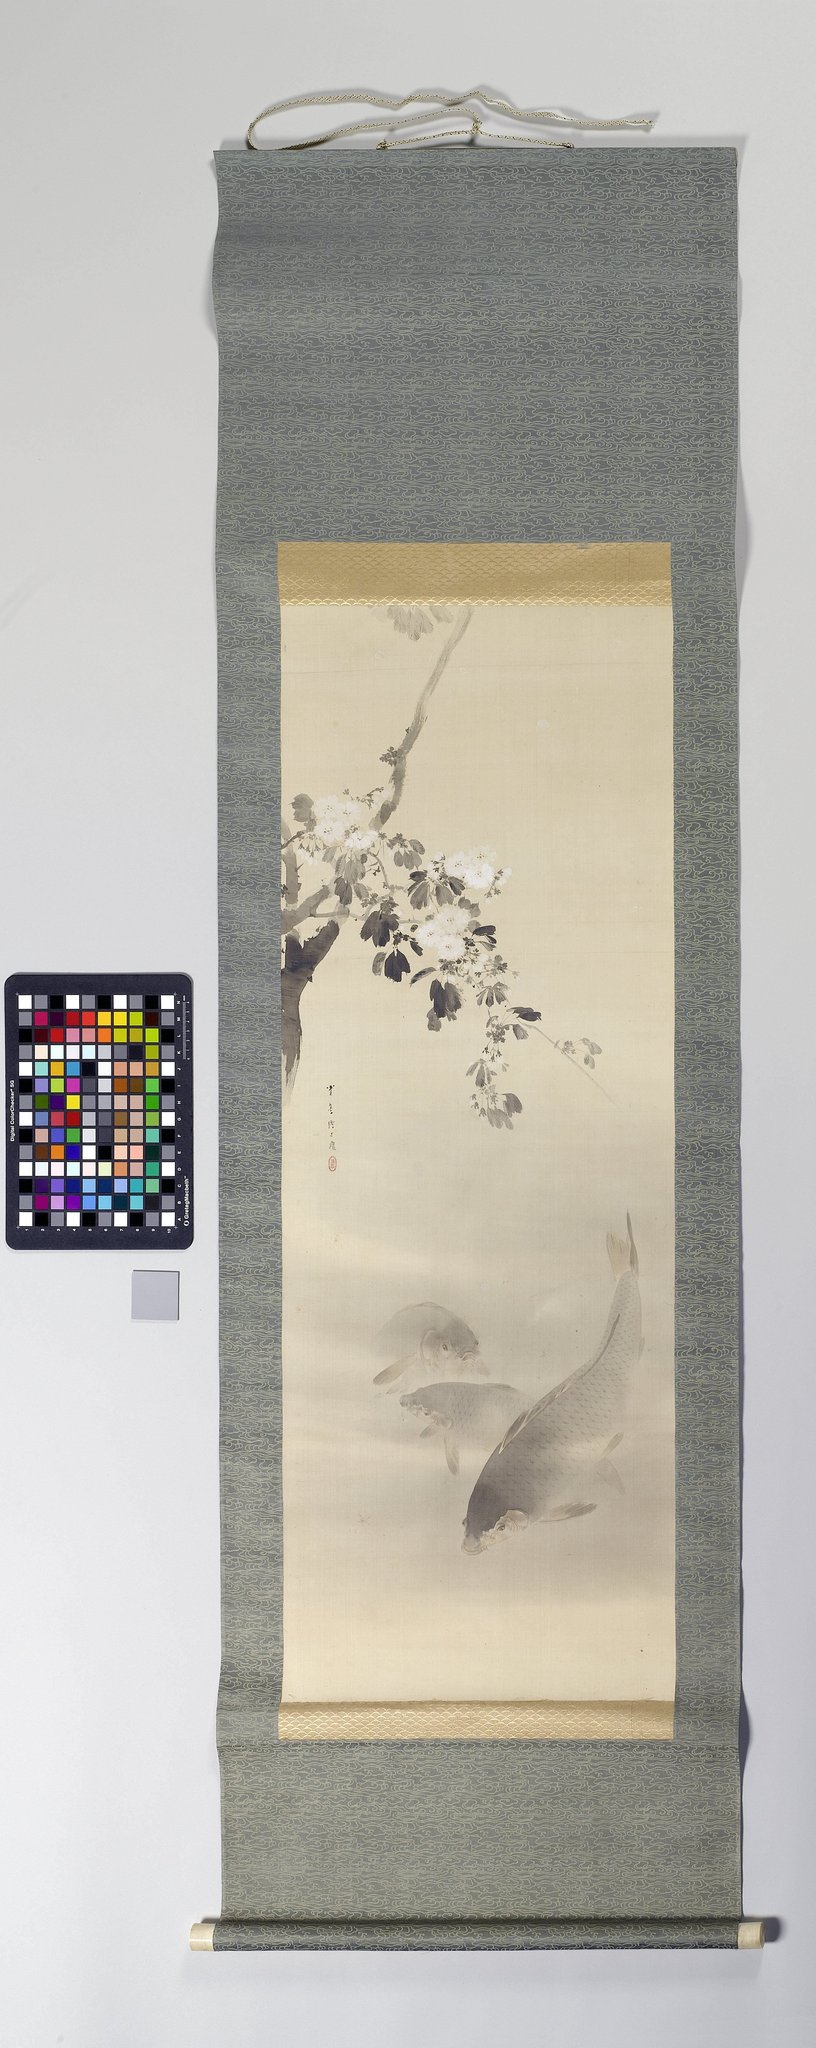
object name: hanging scroll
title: The Four Seasons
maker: watanabe seitei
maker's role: print maker, publisher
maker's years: 1851-1918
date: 1890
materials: ink, silk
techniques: painted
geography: tokyo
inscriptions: seal: ‘Seitei’, signature: ‘Seitei Watanabe’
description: Seitei was a talented painter of animals and flowers. He made prints and paintings on the basis of painstaking nature studies. Here as well he devoted much attention to the cherry blossoms and the detailing of the creatures, for instance the wings of the dragonfly in the painting of summer. In contrast, the waterfall in the background is rendered in broad strokes of the brush.